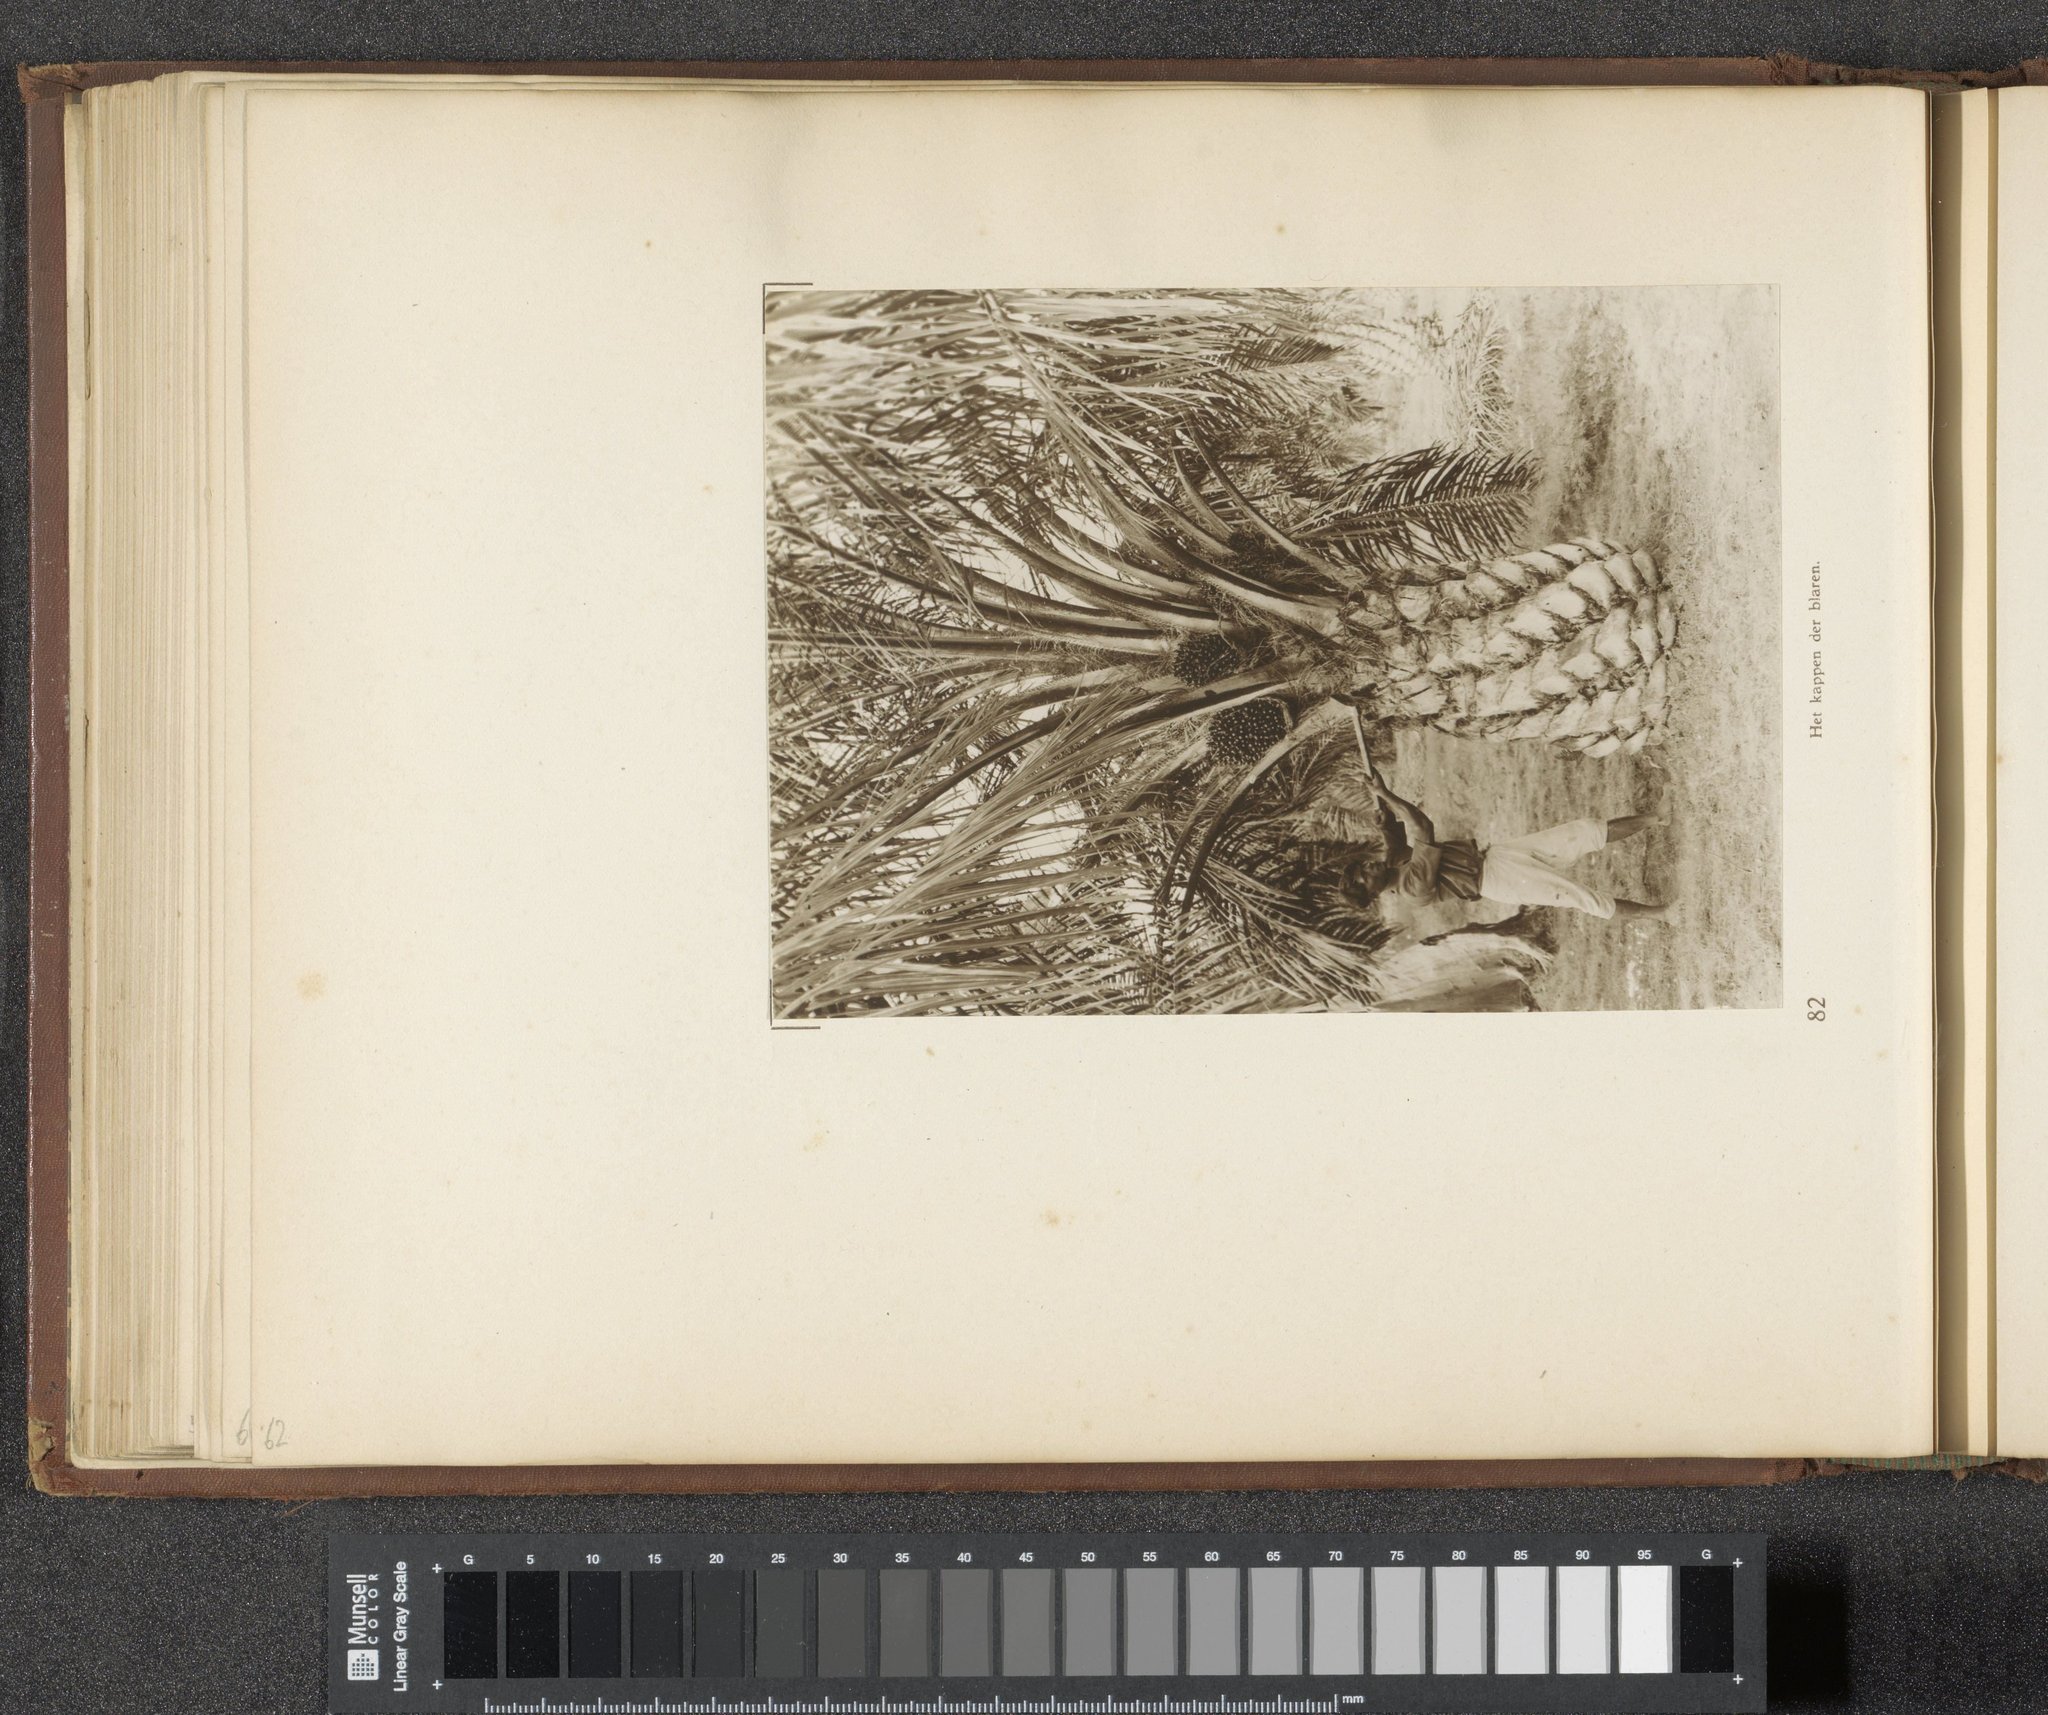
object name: album leaf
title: Pagina 82 van fotoboek van de Algemeene Vereeniging van Rubberplanters ter Oostkust van Sumatra (A.V.R.O.S.)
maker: j.w. meyster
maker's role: fotograaf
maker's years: 1887-1945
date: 1924-1925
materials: paper, photographic support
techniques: printing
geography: dutch east indies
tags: plantation, (non-fruit) products of plants or trees: rubber, trees: palm-tree, sumatra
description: Boekpagina met een foto van een Indische man die palmbladen kapt op een plantage van de Algemeene Vereeniging van Rubberplanters ter Oostkust van Sumatra (A.V.R.O.S.). Onderdeel van een fotoboek van de Algemeene Vereeniging van Rubberplanters ter Oostkust van Sumatra (A.V.R.O.S.).